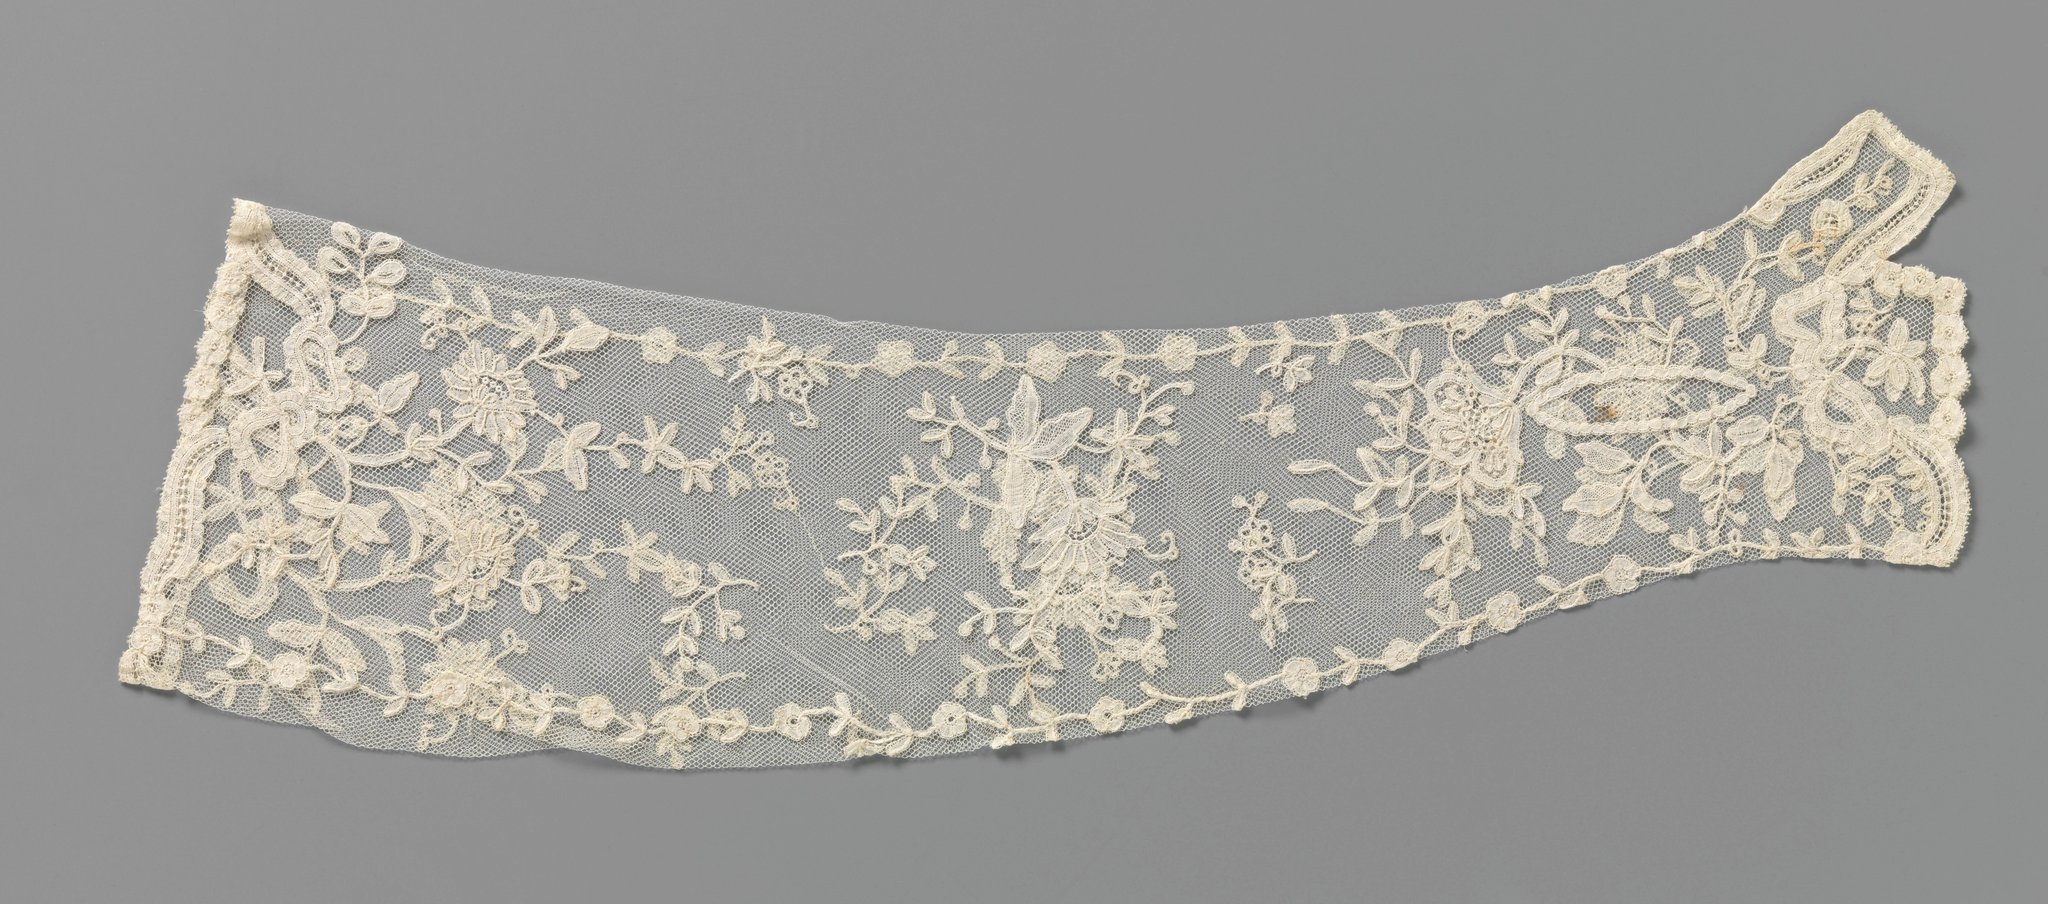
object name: womenswear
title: Mitaine van applicatiekant met rozen en margrieten en strikken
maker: Anonymous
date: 1900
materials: linen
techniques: lace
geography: brussels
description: Mitaine van naturelkleurige Brusselse applicatiekant: kloskant met naaldkantsiersteken geappliceerd op machinale tule. Het model is als rond geknipte mouwen, hol van binnen en bol van buiten. Het patroon is aan beide zijden gelijk en heeft margrieten en andere bloemen met een strik bijeengebonden. In het midden heeft het een los boeket bloemen en gestrooide rozeknoppen, omlijst door een ijle slinger met rozen. De motieven zijn gemaakt in netslag en linnenslag met opengewerkte randjes en op verschillende plekken geaccentueerd door reliëfcontourlijnen. In bloemharten en linten zijn naaldkantsiersteken toegepast.